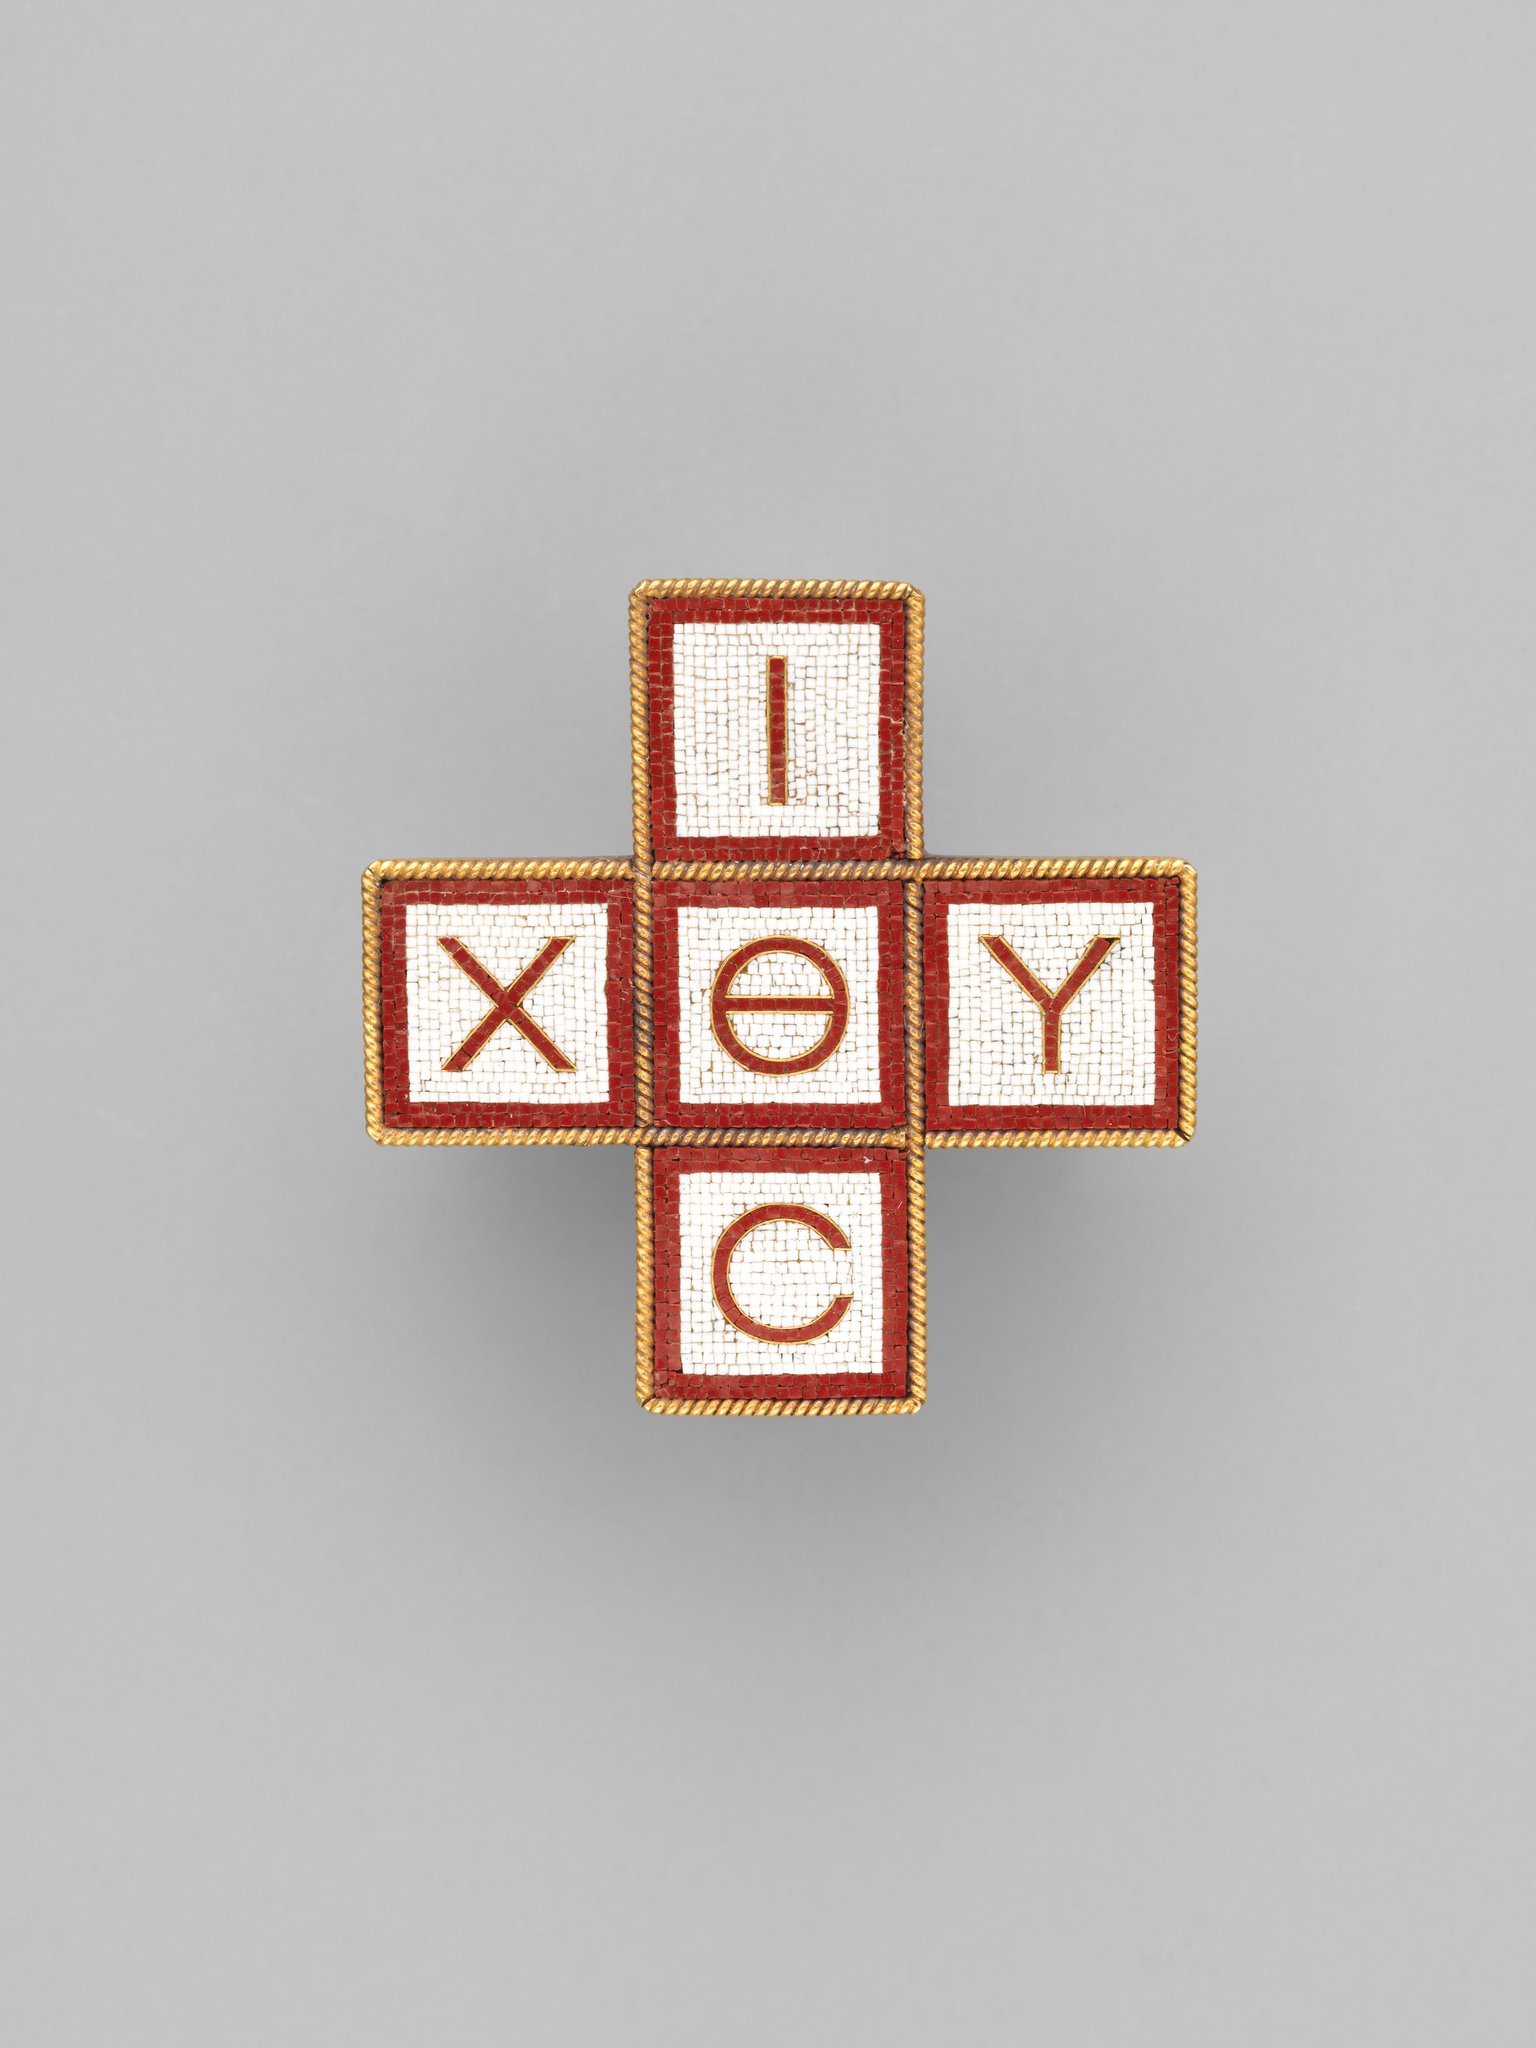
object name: brooch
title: Brooch with Greek letters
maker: castellani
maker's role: maker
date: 1860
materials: glass, gold